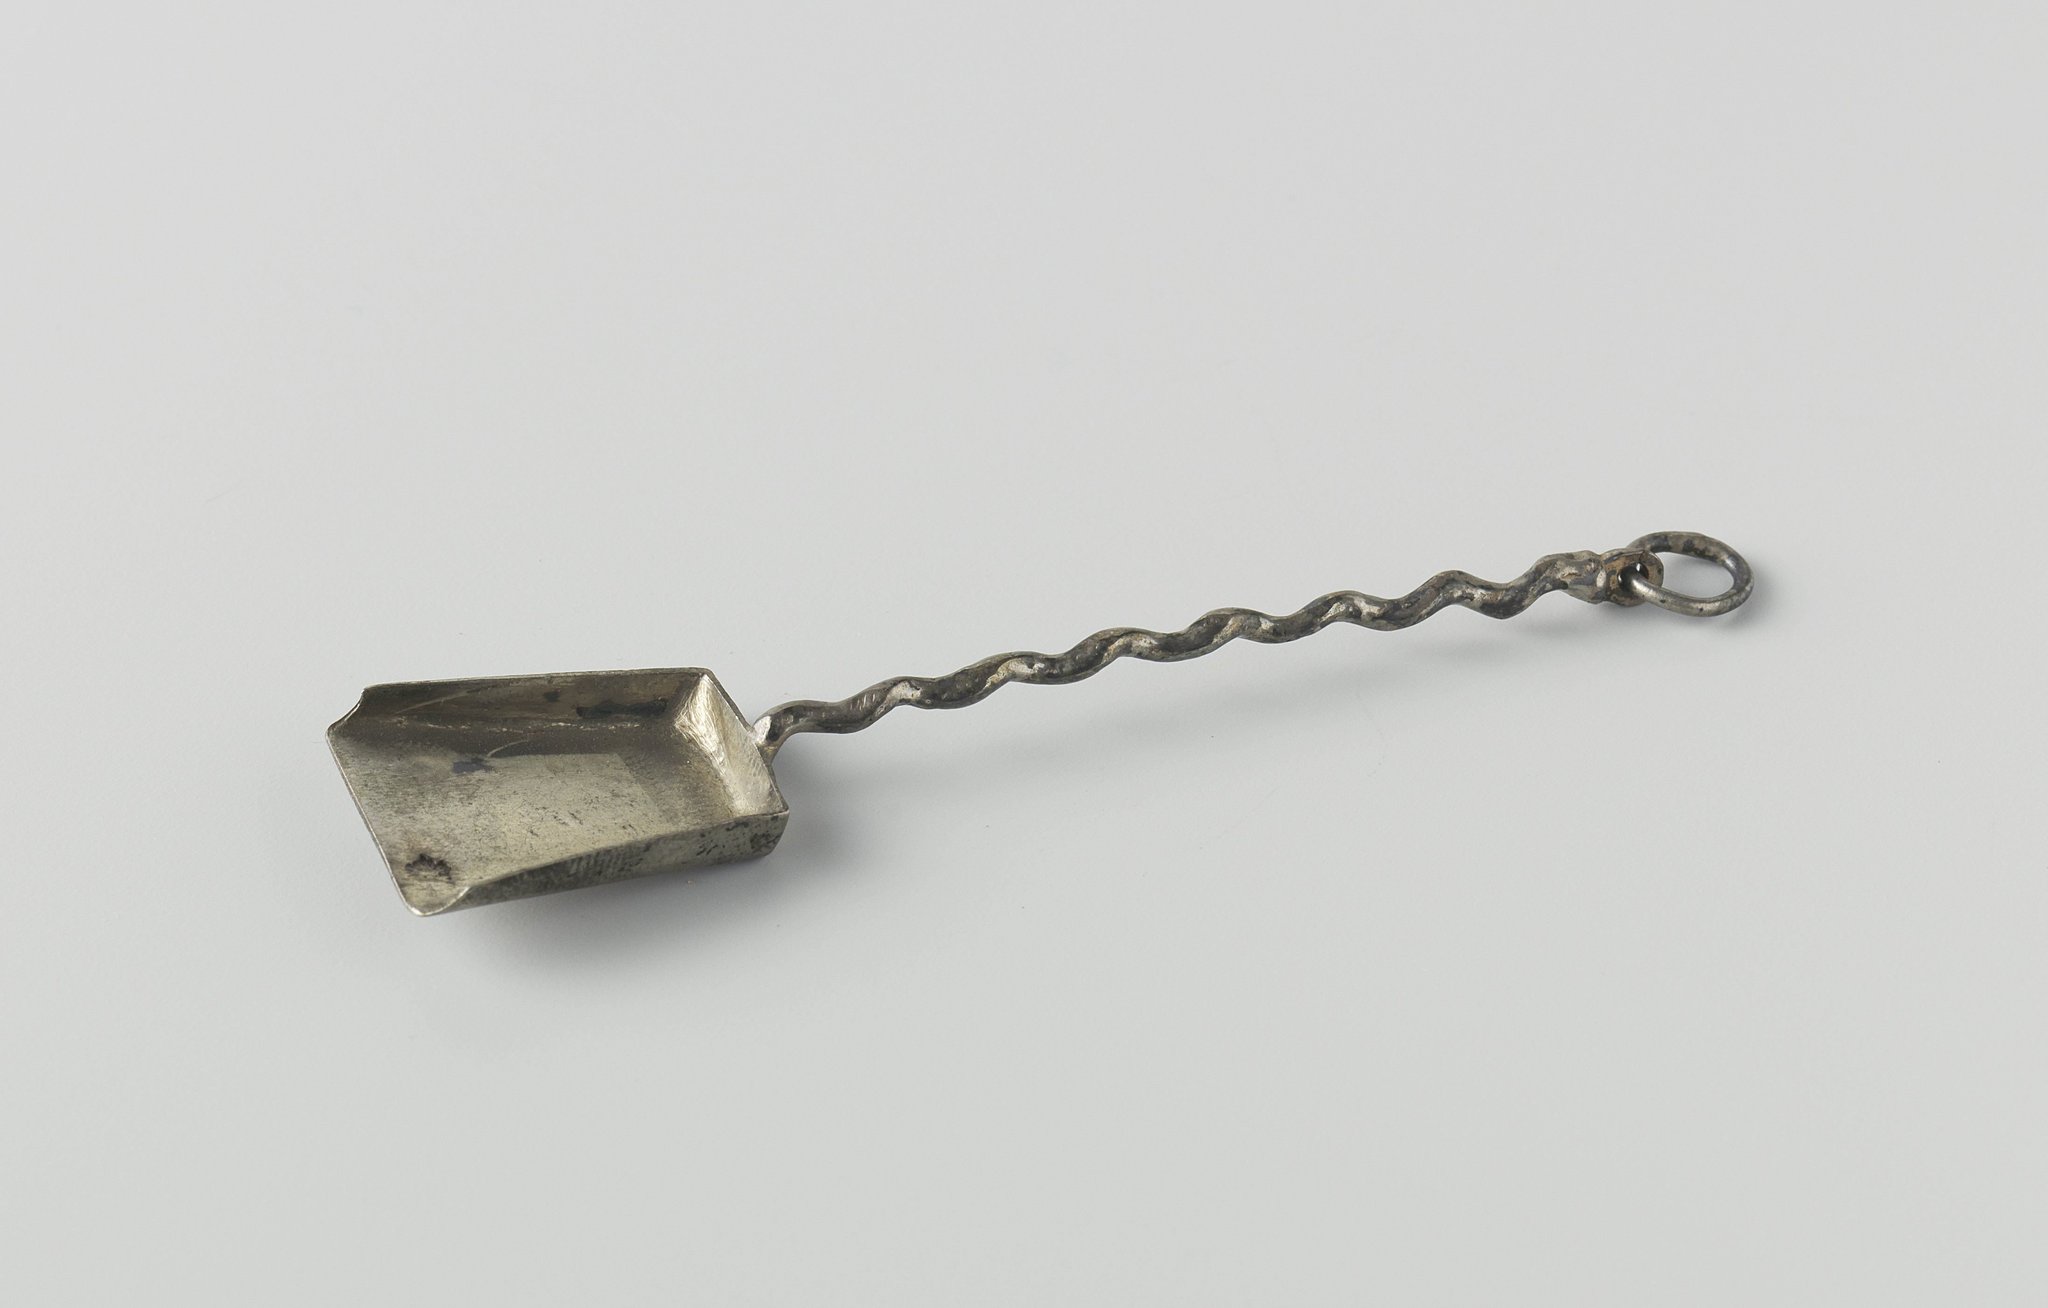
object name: miniature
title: Asschep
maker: Anonymous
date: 1700-1800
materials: silver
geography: netherlands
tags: implements ~ fire-place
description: Asschep met lange steel. De steel is gedraaid en heeft aan het uiteinde een ring. De asschep is gemerkt met een stralende zon (?) in een gevormd schild.